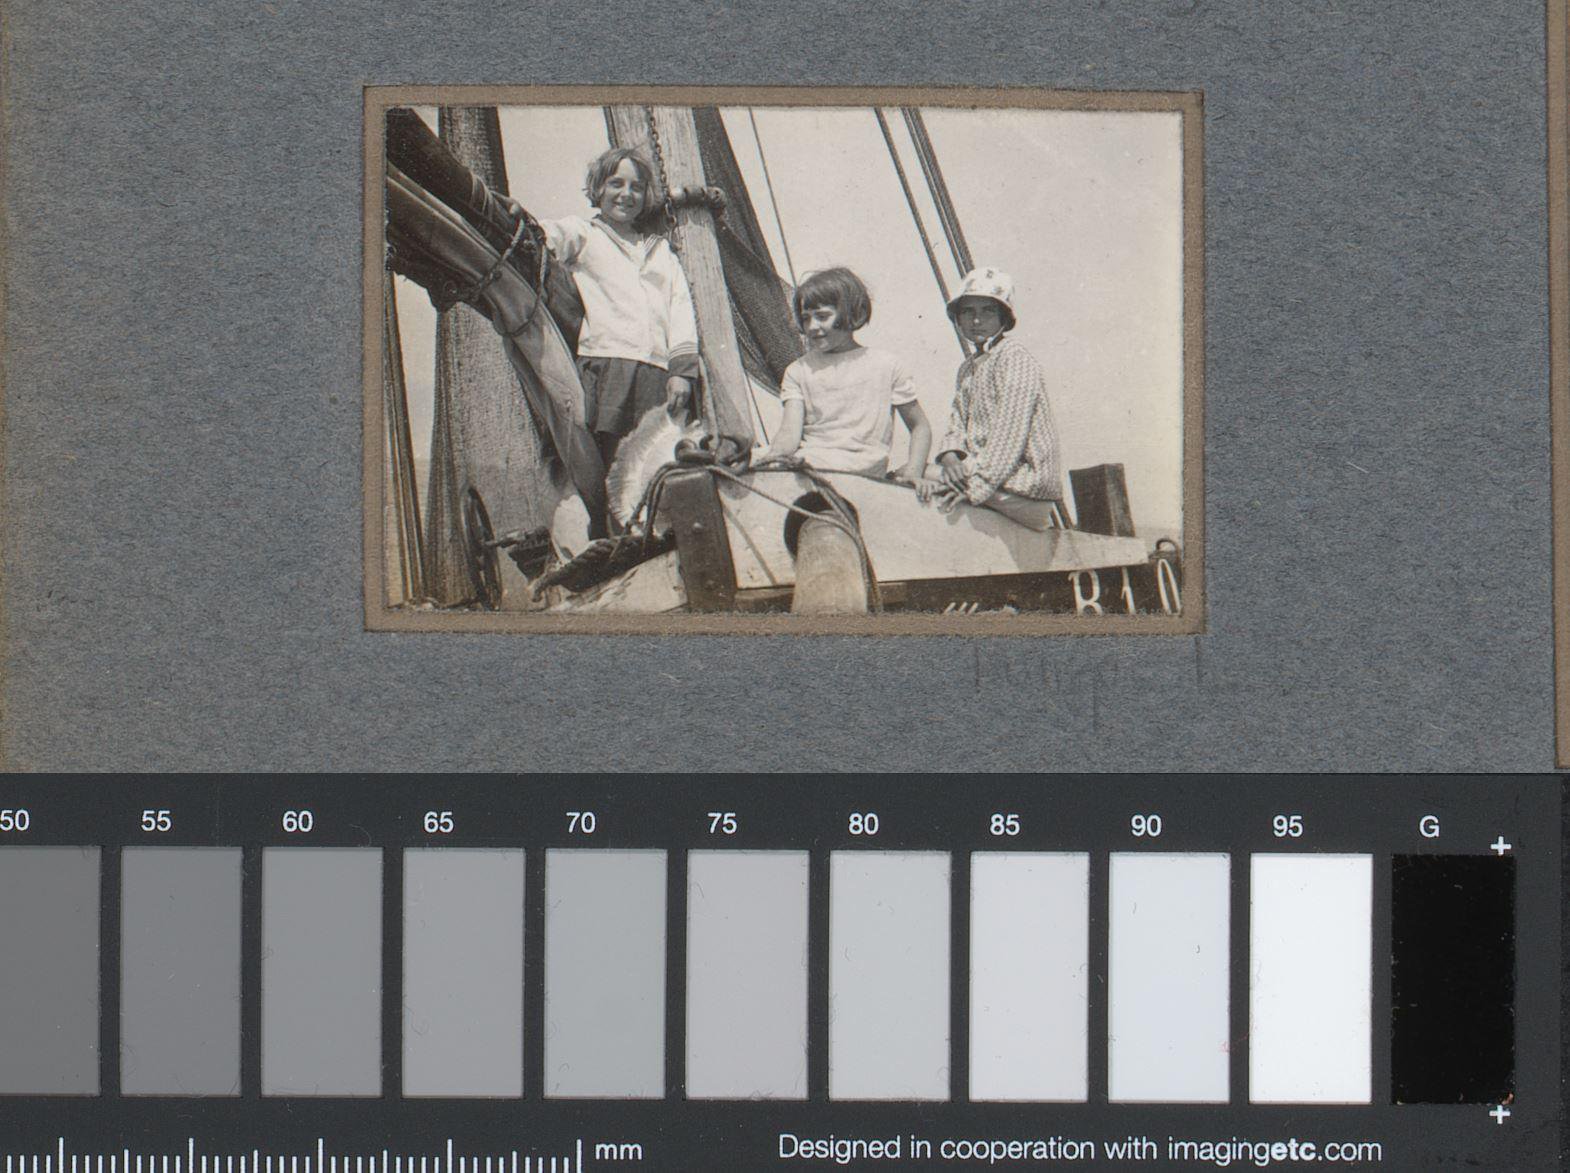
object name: album leaf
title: Drie kinderen op een zeilboot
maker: Anonymous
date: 1925-1934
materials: photographic support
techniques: gelatin silver print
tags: sailing-ship, sailing-boat, child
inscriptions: inscription: ‘Opnamen gemaakt met de Autografische Vestzak-"Kodak"/ Model B./ Afdrukken gemaakt op "Velox" papier.’